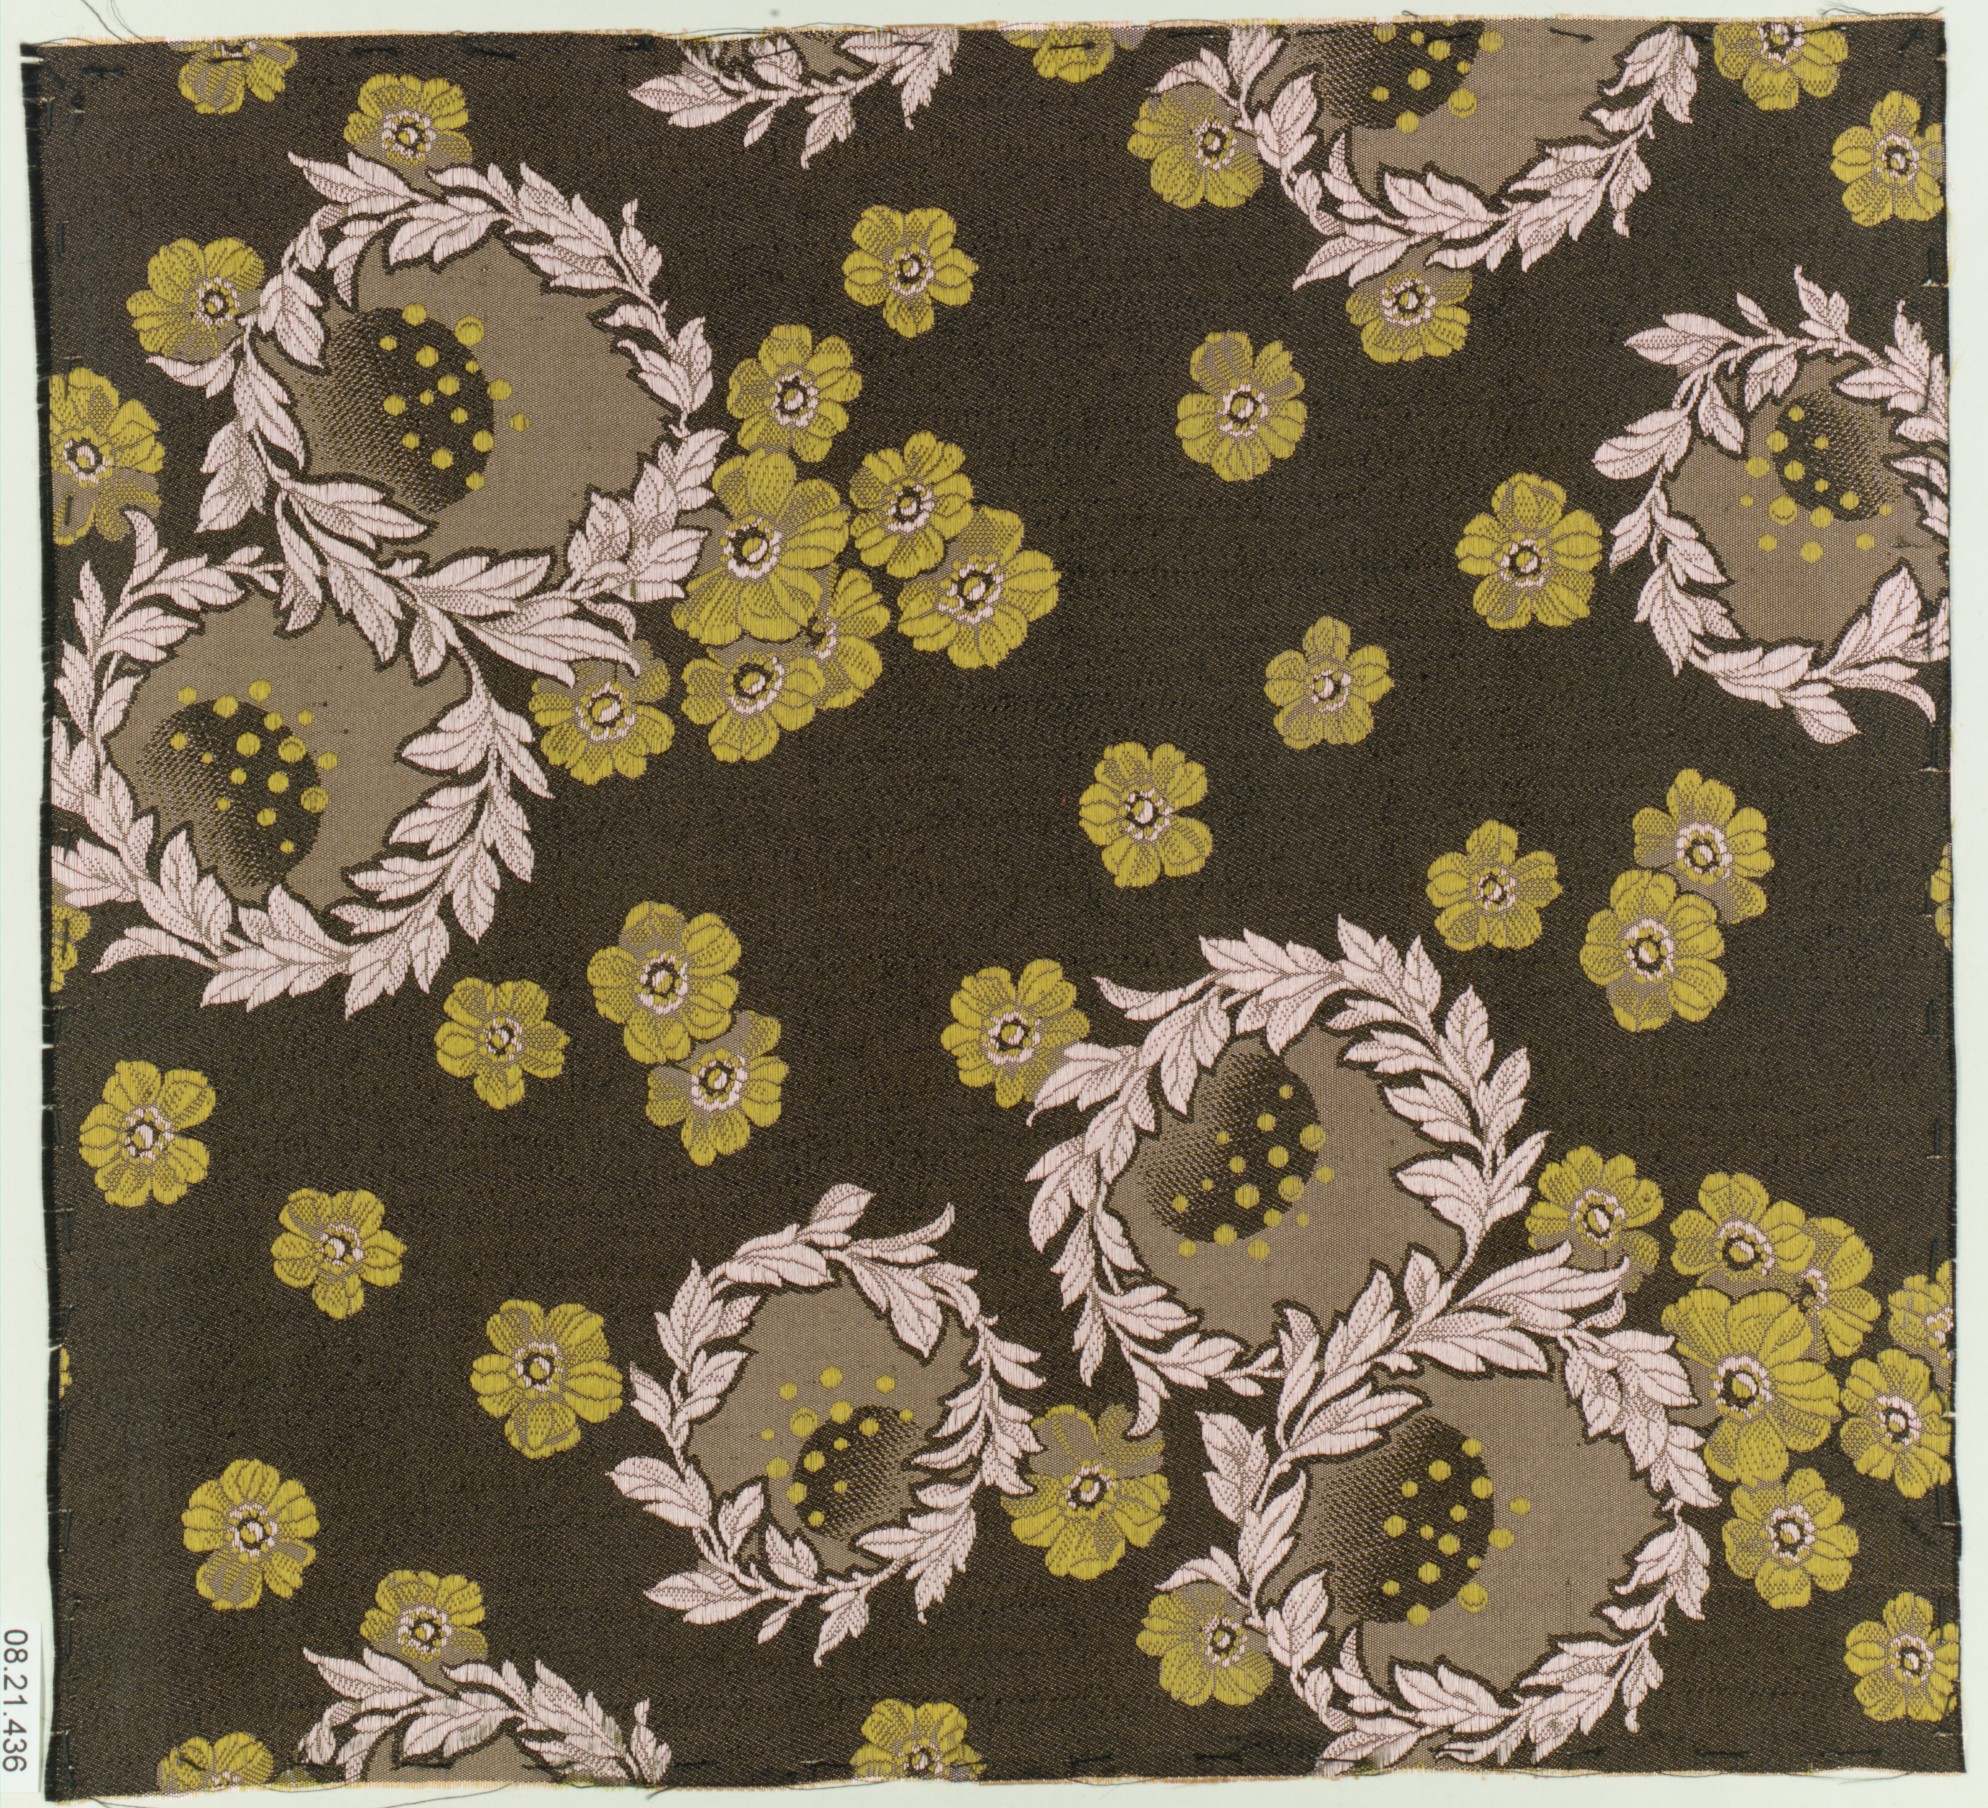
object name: textile sample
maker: Anonymous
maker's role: designer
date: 1900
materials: silk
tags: flowers,leaves